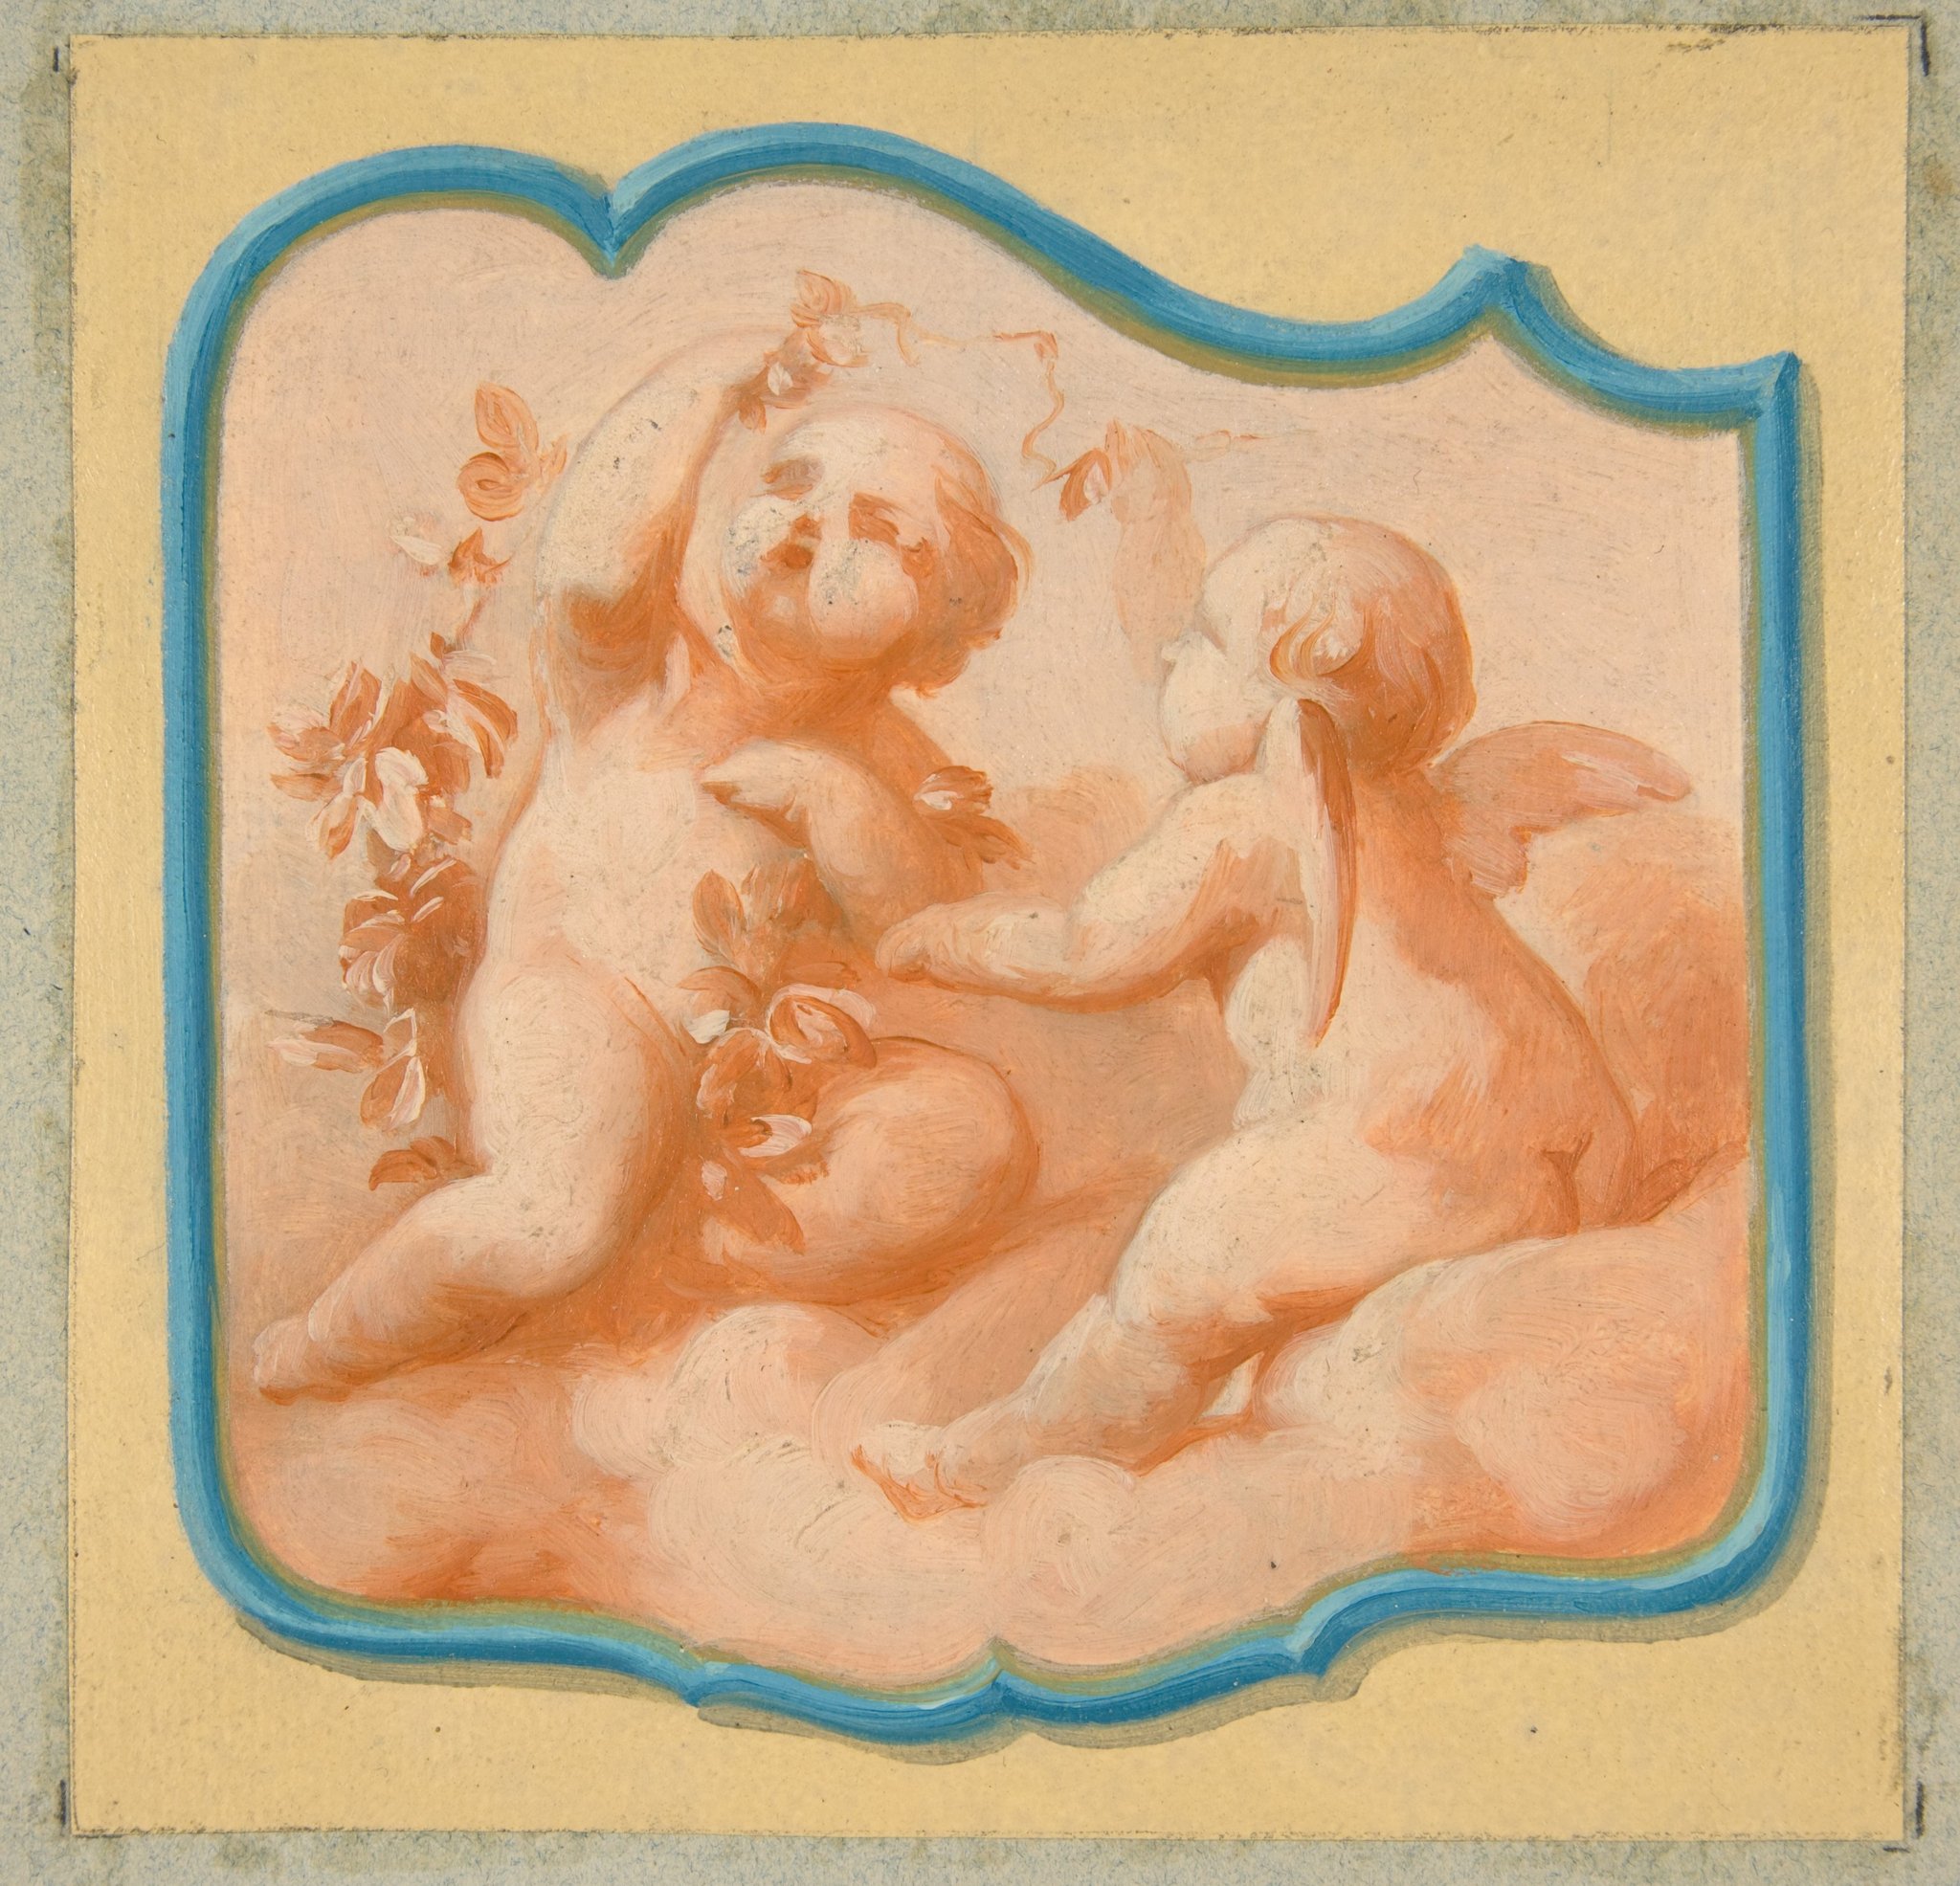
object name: drawing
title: Two putti on clouds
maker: jules-edmond-charles lachaise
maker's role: artist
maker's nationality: french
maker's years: 1897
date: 1851-1900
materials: graphite, oil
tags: putti